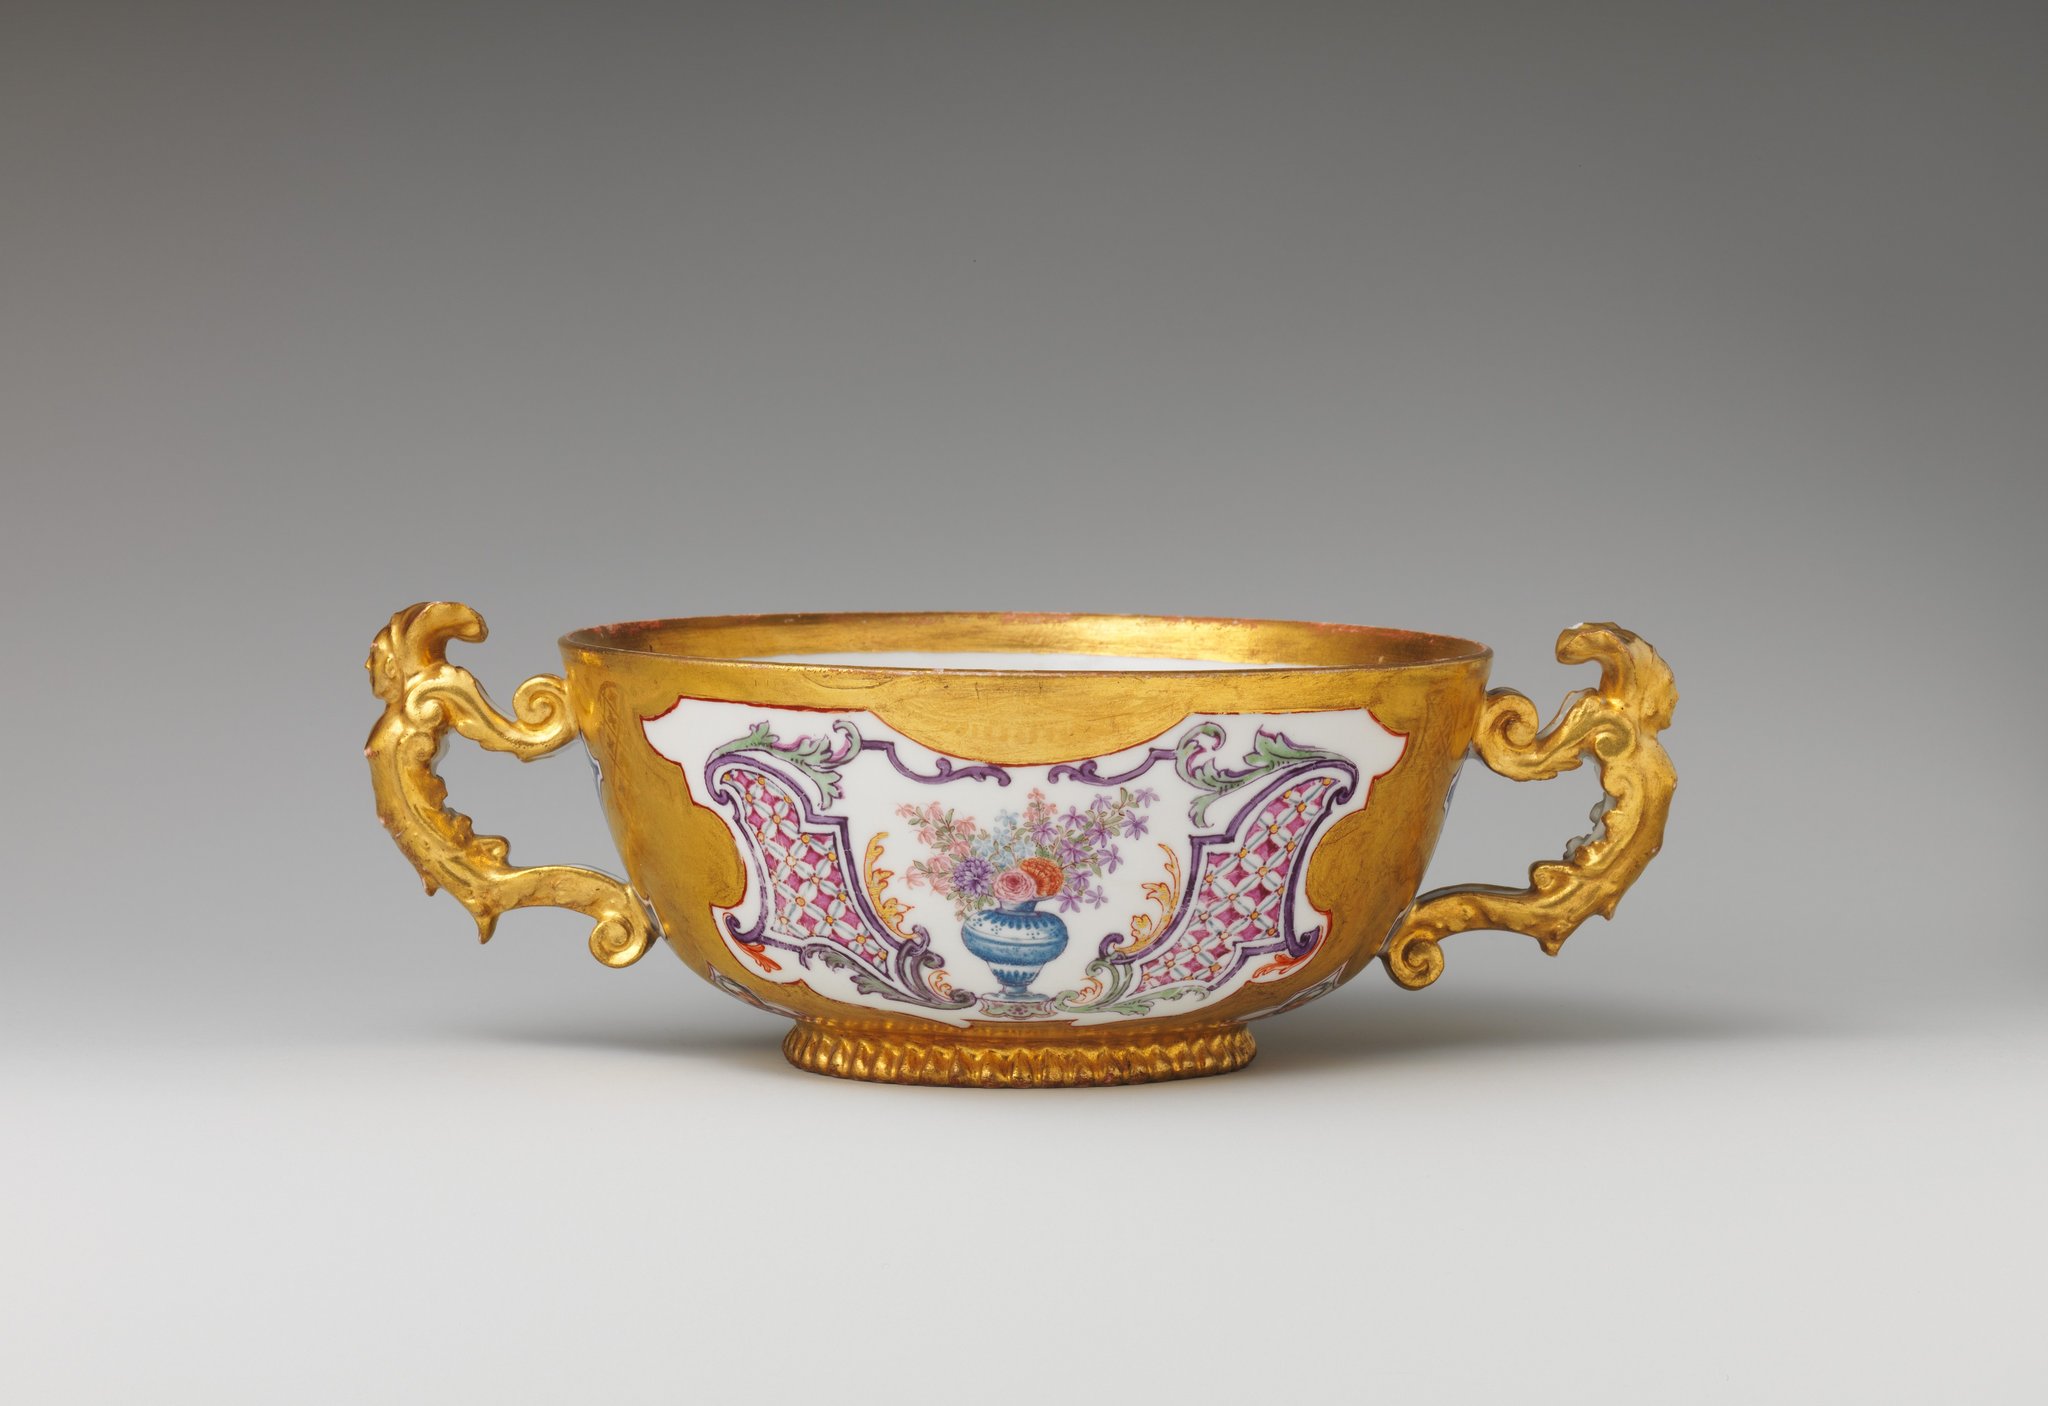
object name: bowl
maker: vienna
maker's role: manufactory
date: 1735-1740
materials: hard paste porcelain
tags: flowers